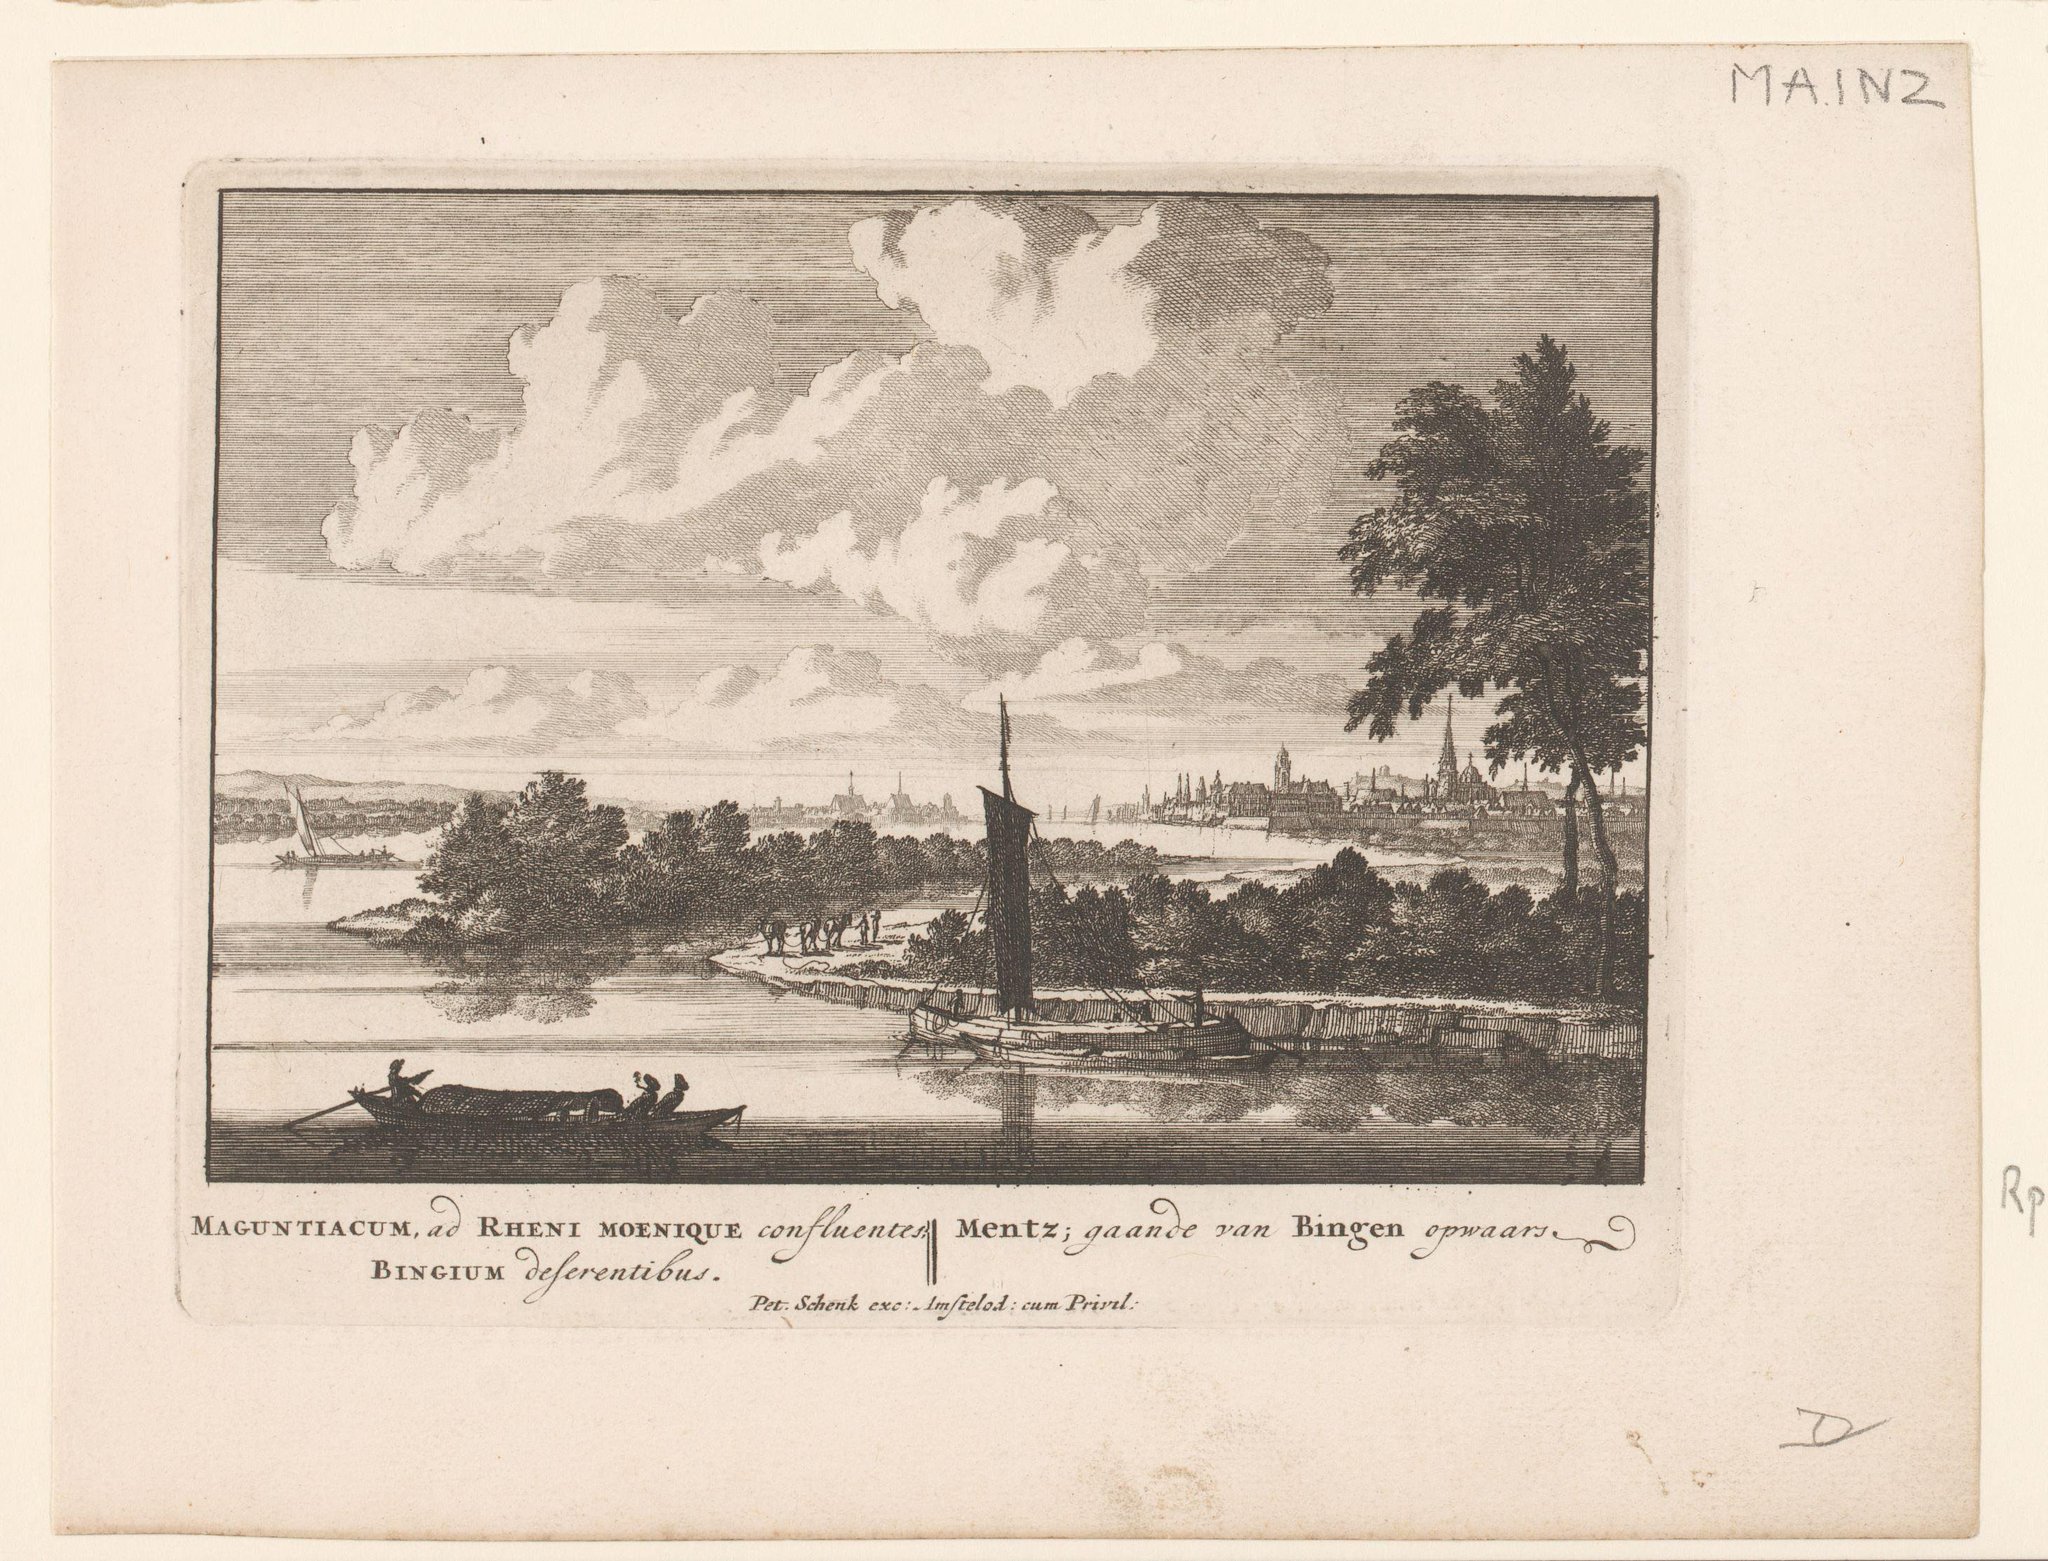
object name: print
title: Mentz; gaande van Bingen opwaars / Maguntiacum, ad Rheni moenique confluentes Bingium deferentibus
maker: pieter schenk (i)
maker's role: print maker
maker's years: 1660-1711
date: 1694-1697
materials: paper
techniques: engraving, etching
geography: amsterdam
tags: river, prospect of city, town panorama, silhouette of city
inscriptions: collector's mark: Lugt 2228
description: Prent ook gebruikt in: Admirandorum quadruplex spectaculum / delectum, pictum, et aeri in cisum, per Johannem van Call. Amsterdam: Pieter Schenk (I), ca. 1694-1697.